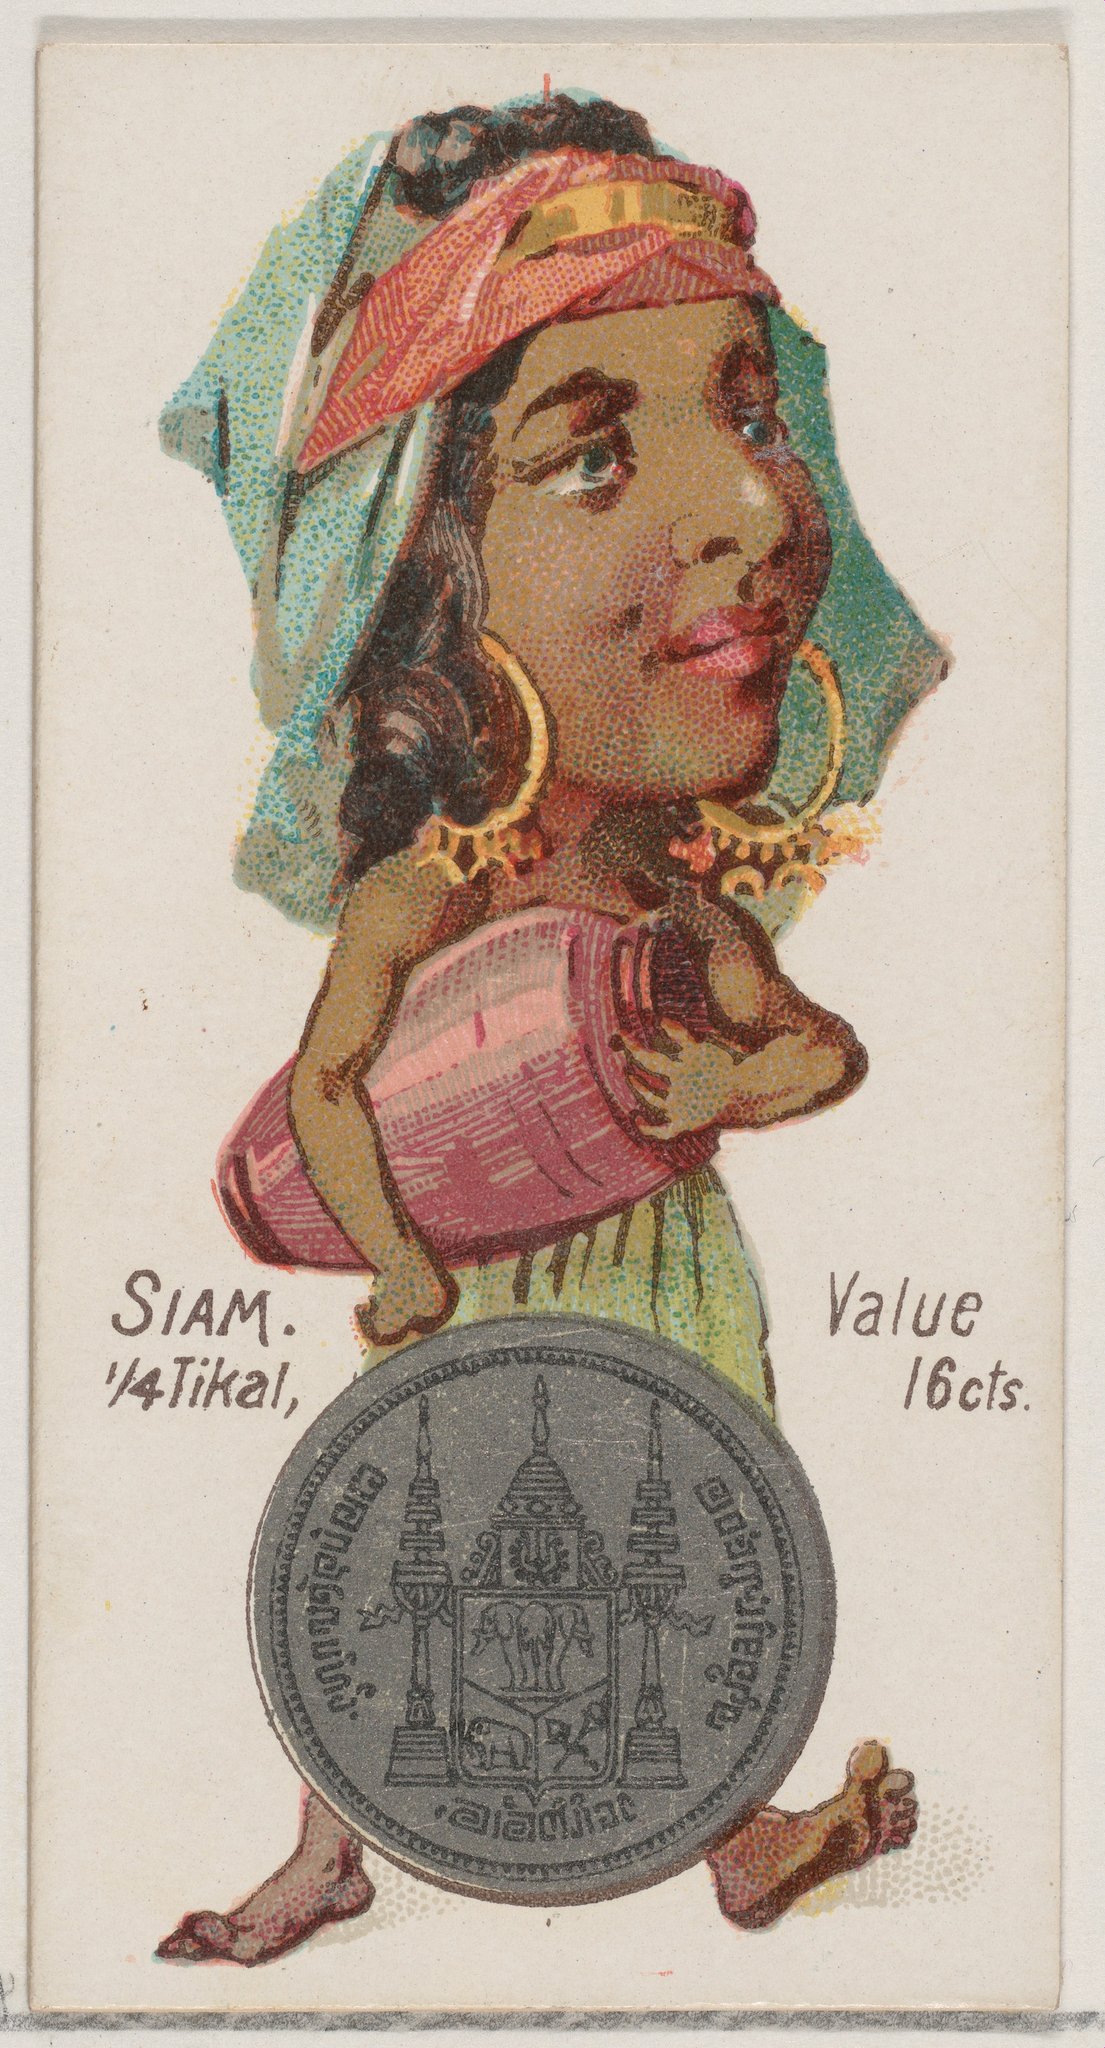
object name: print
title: Caricatured figure from Siam, 1/4 Tikal, from the series Coins of All Nations (N72, variation 1) for Duke brand cigarettes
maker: w. duke, sons & co.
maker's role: publisher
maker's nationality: american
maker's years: 1870-1920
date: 1889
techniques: color lithograph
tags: coins